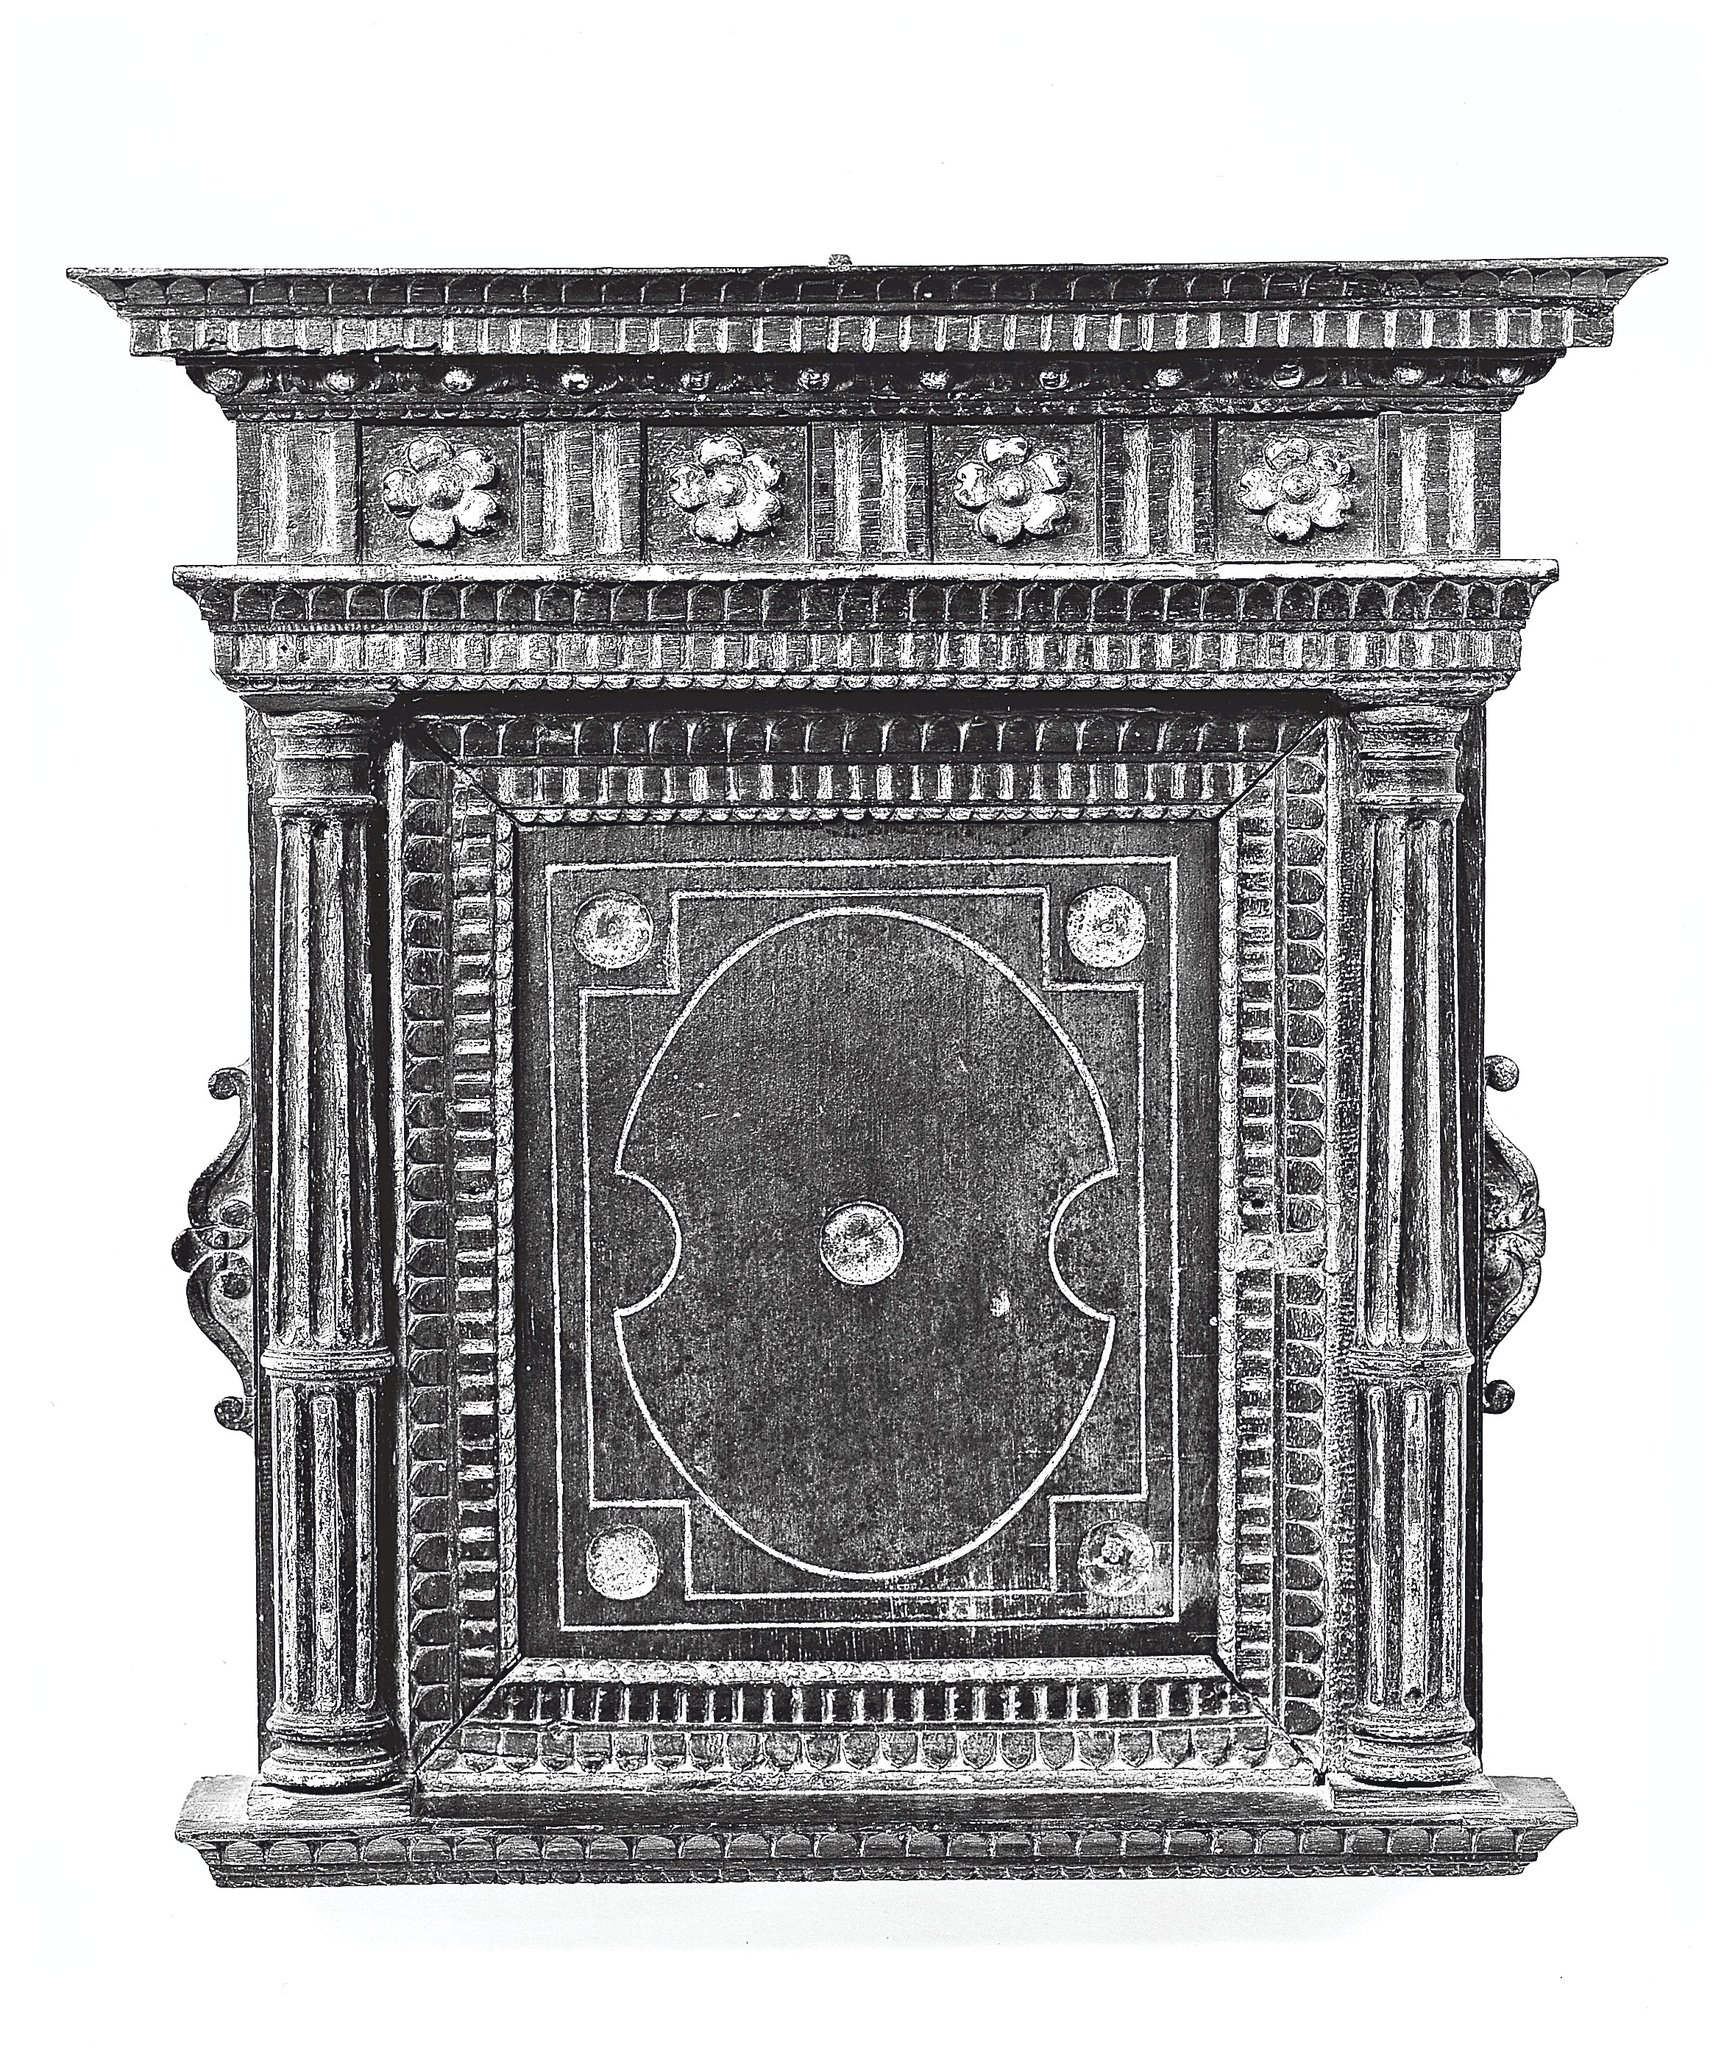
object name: frame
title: Tabernacle Frame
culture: italian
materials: wood